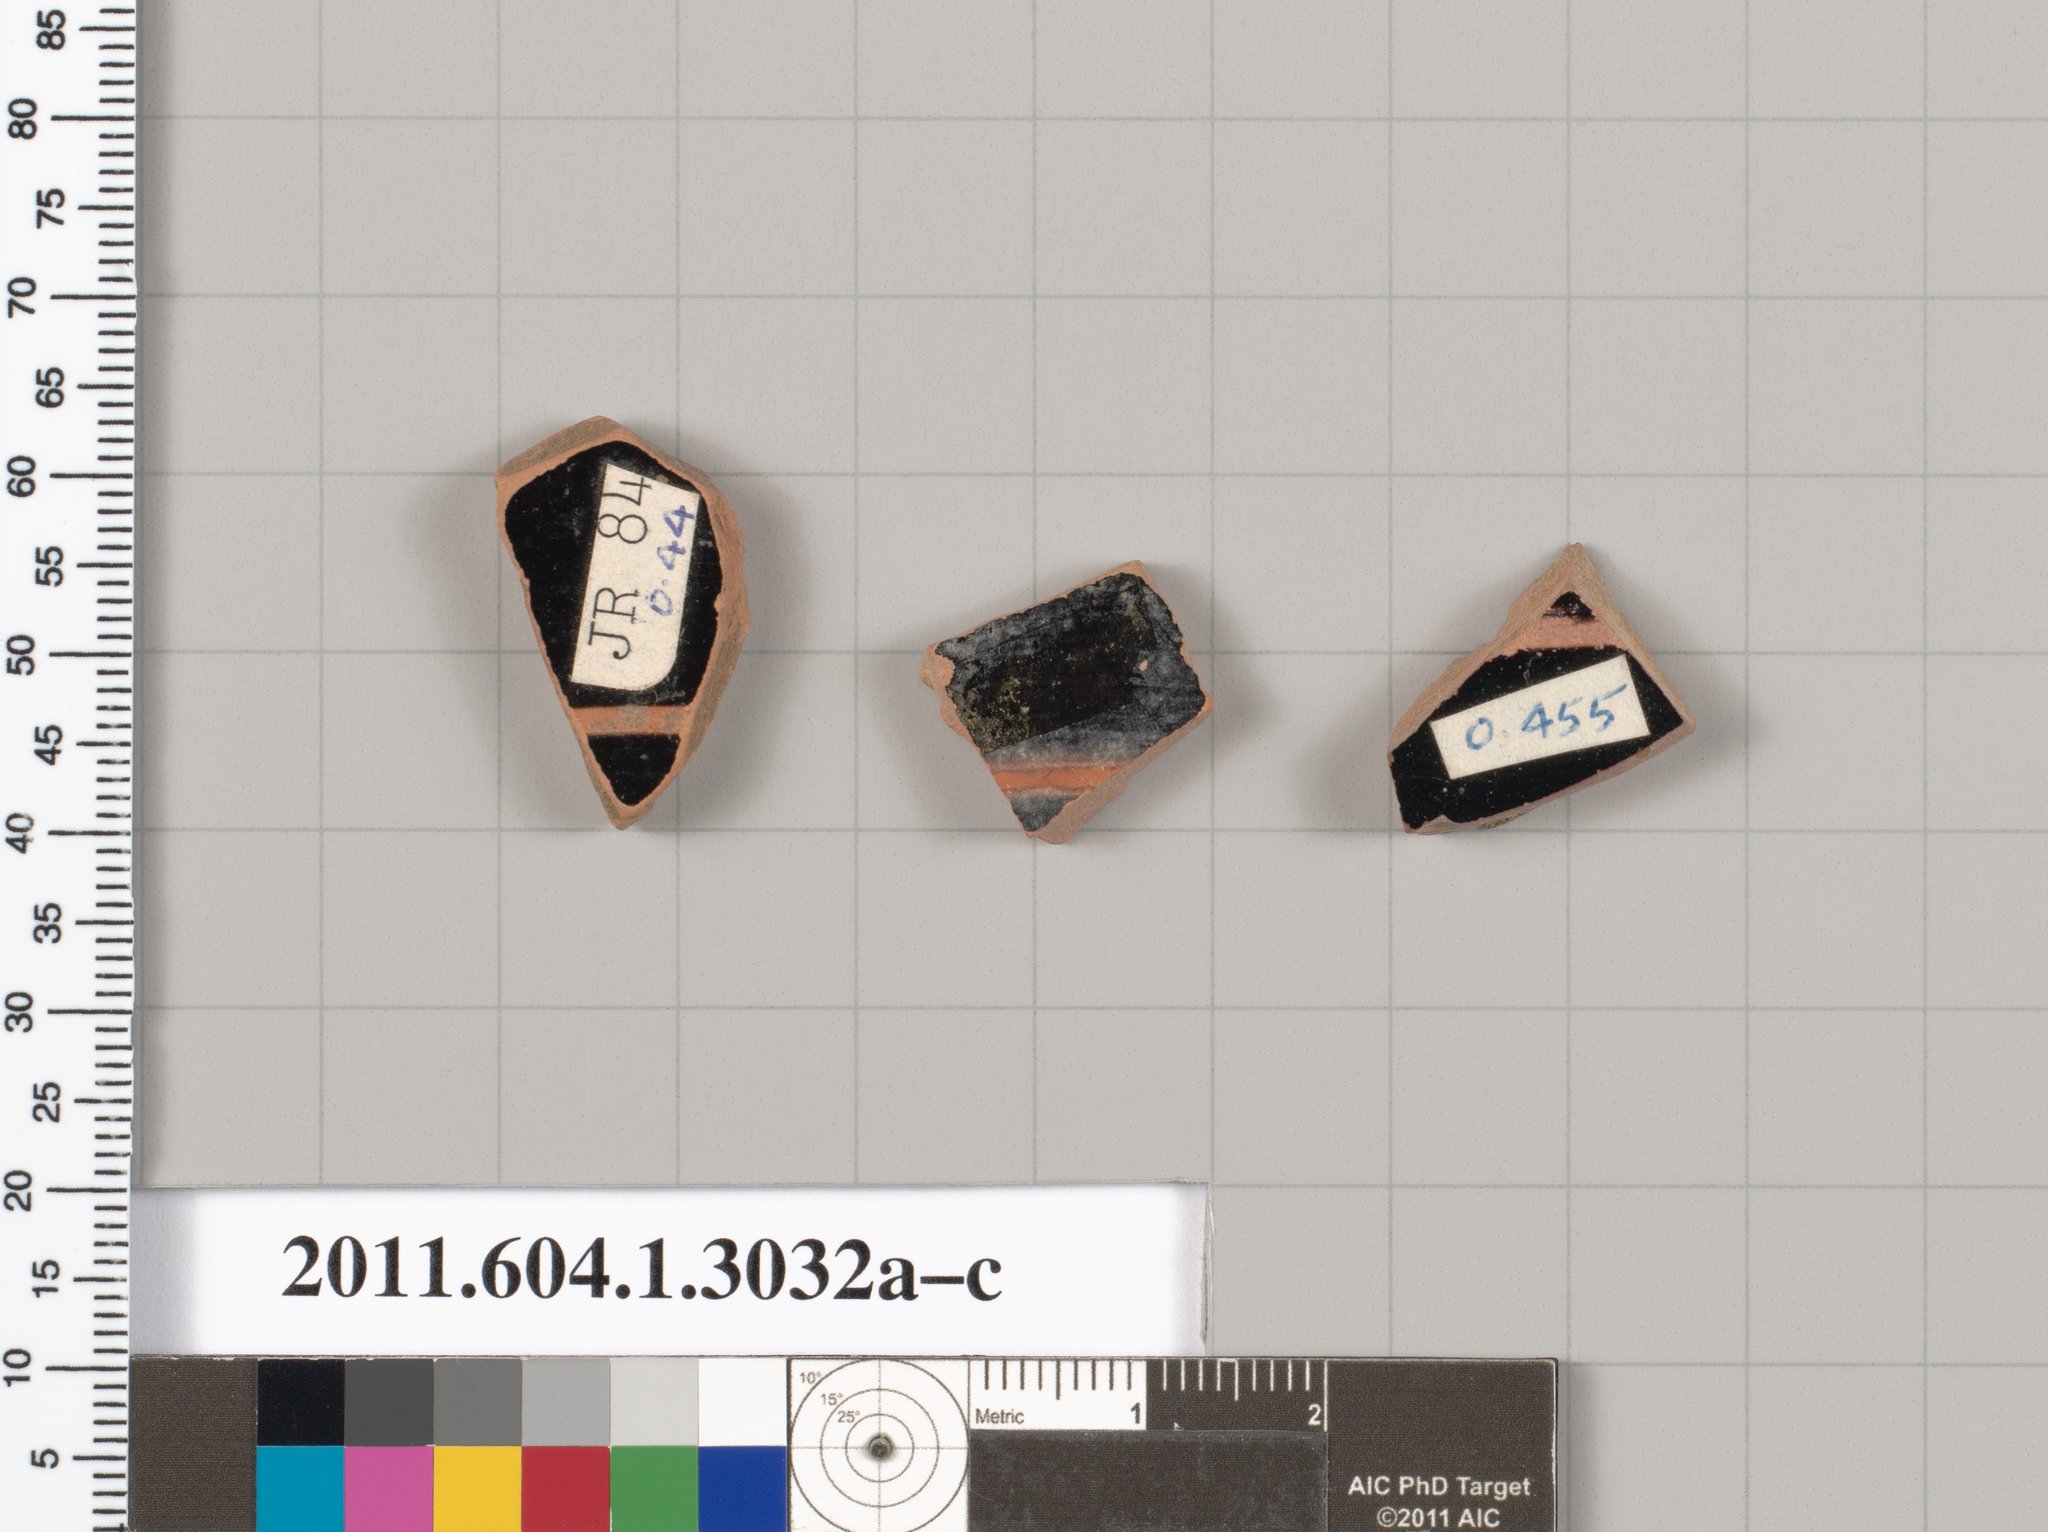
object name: kylix fragment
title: Terracotta fragments of kylikes (drinking cups)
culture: greek, attic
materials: terracotta